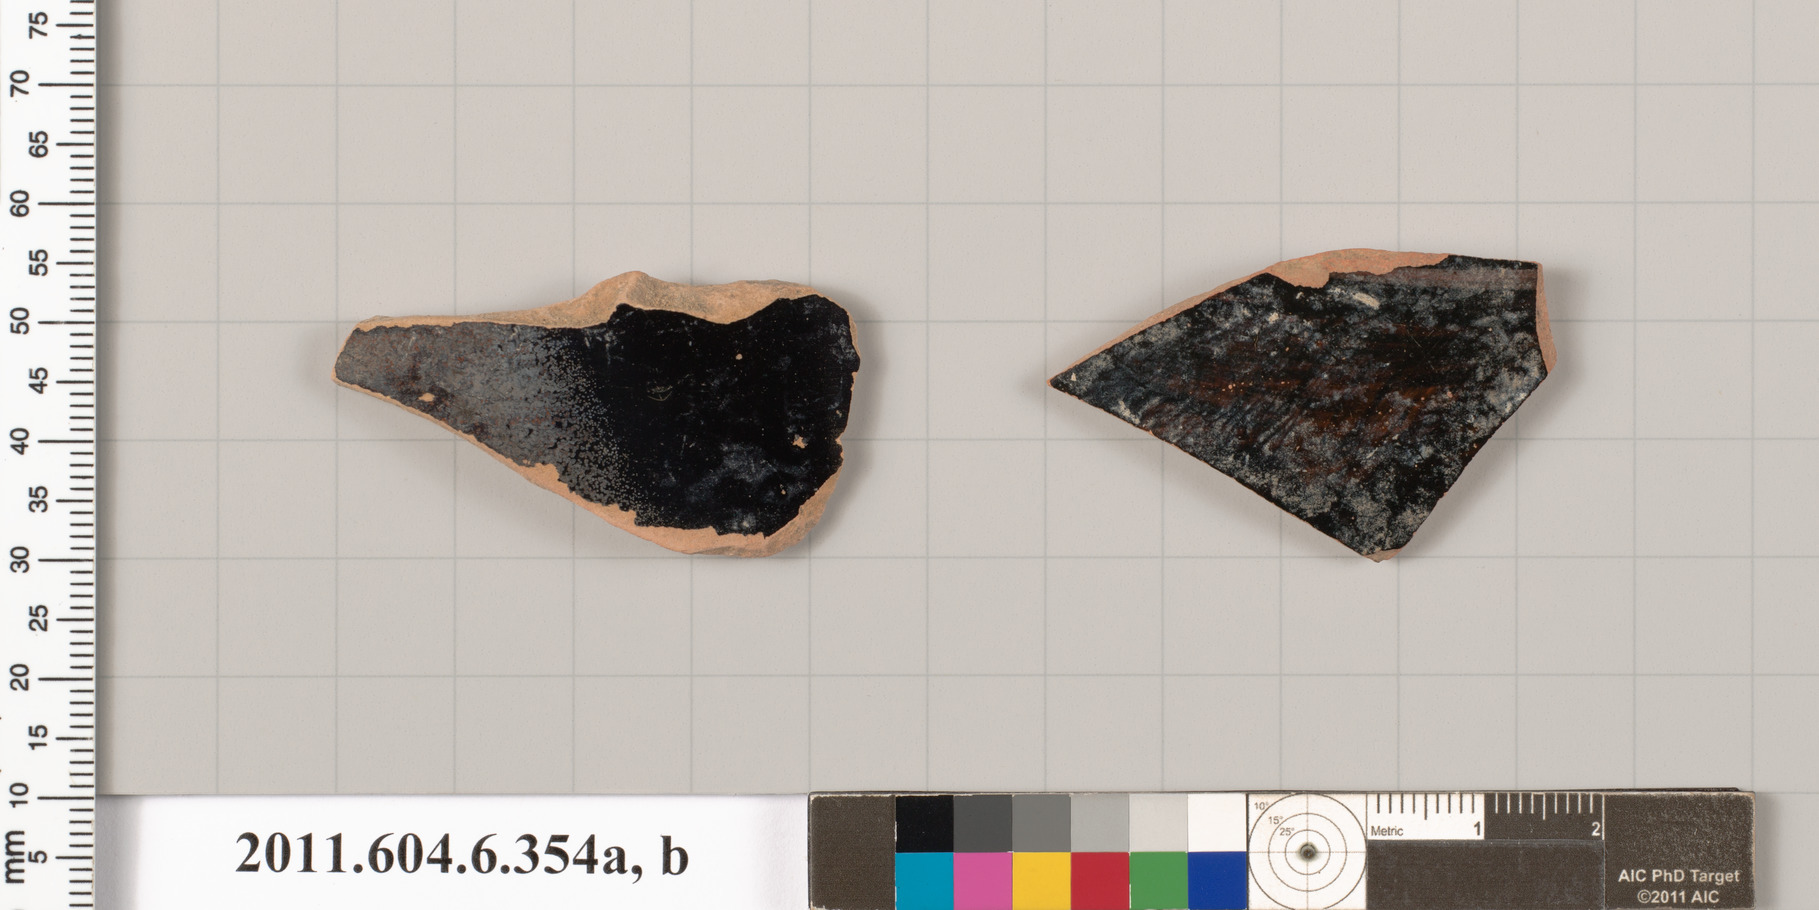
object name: undetermined closed shape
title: Terracotta fragments of closed shapes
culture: greek, attic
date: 600-401 BCE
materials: terracotta